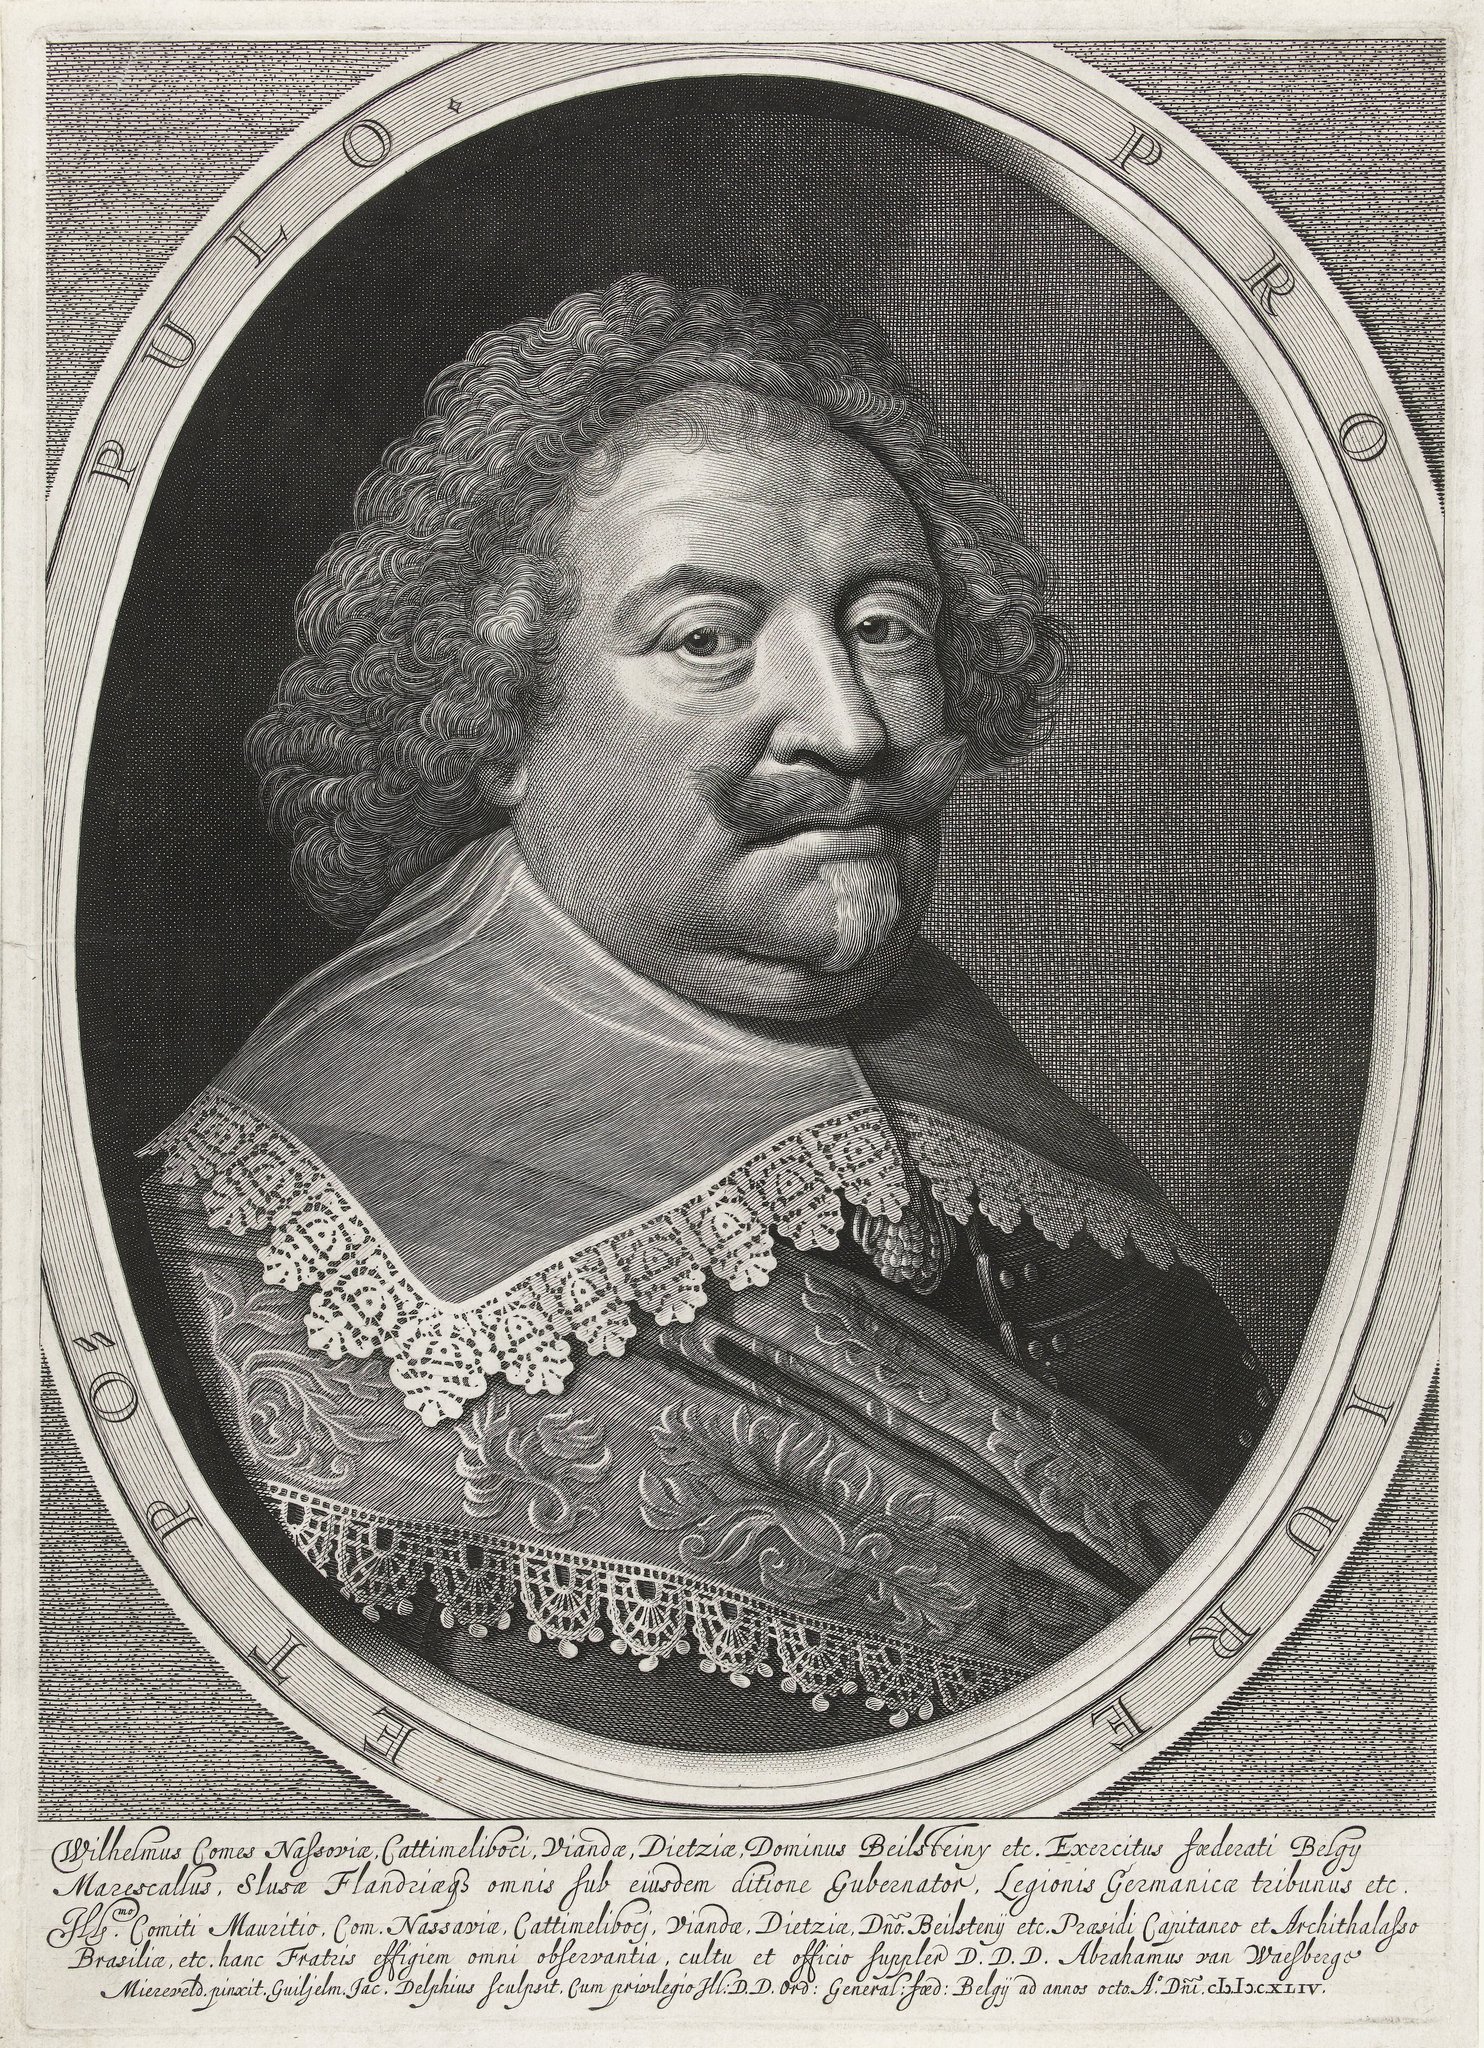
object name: print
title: Portret van Willem, graaf van Nassau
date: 1644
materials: paper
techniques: engraving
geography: delft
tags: commander-in-chief, general, marshal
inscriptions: collector's mark: Lugt 1119, collector's mark: Lugt 2228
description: Portret van Willem, graaf van Nassau, borststuk met kanten kraag en harnas in ovale omlijsting met opschrift. In ondermarge Latijnse tekst in vijf regels.